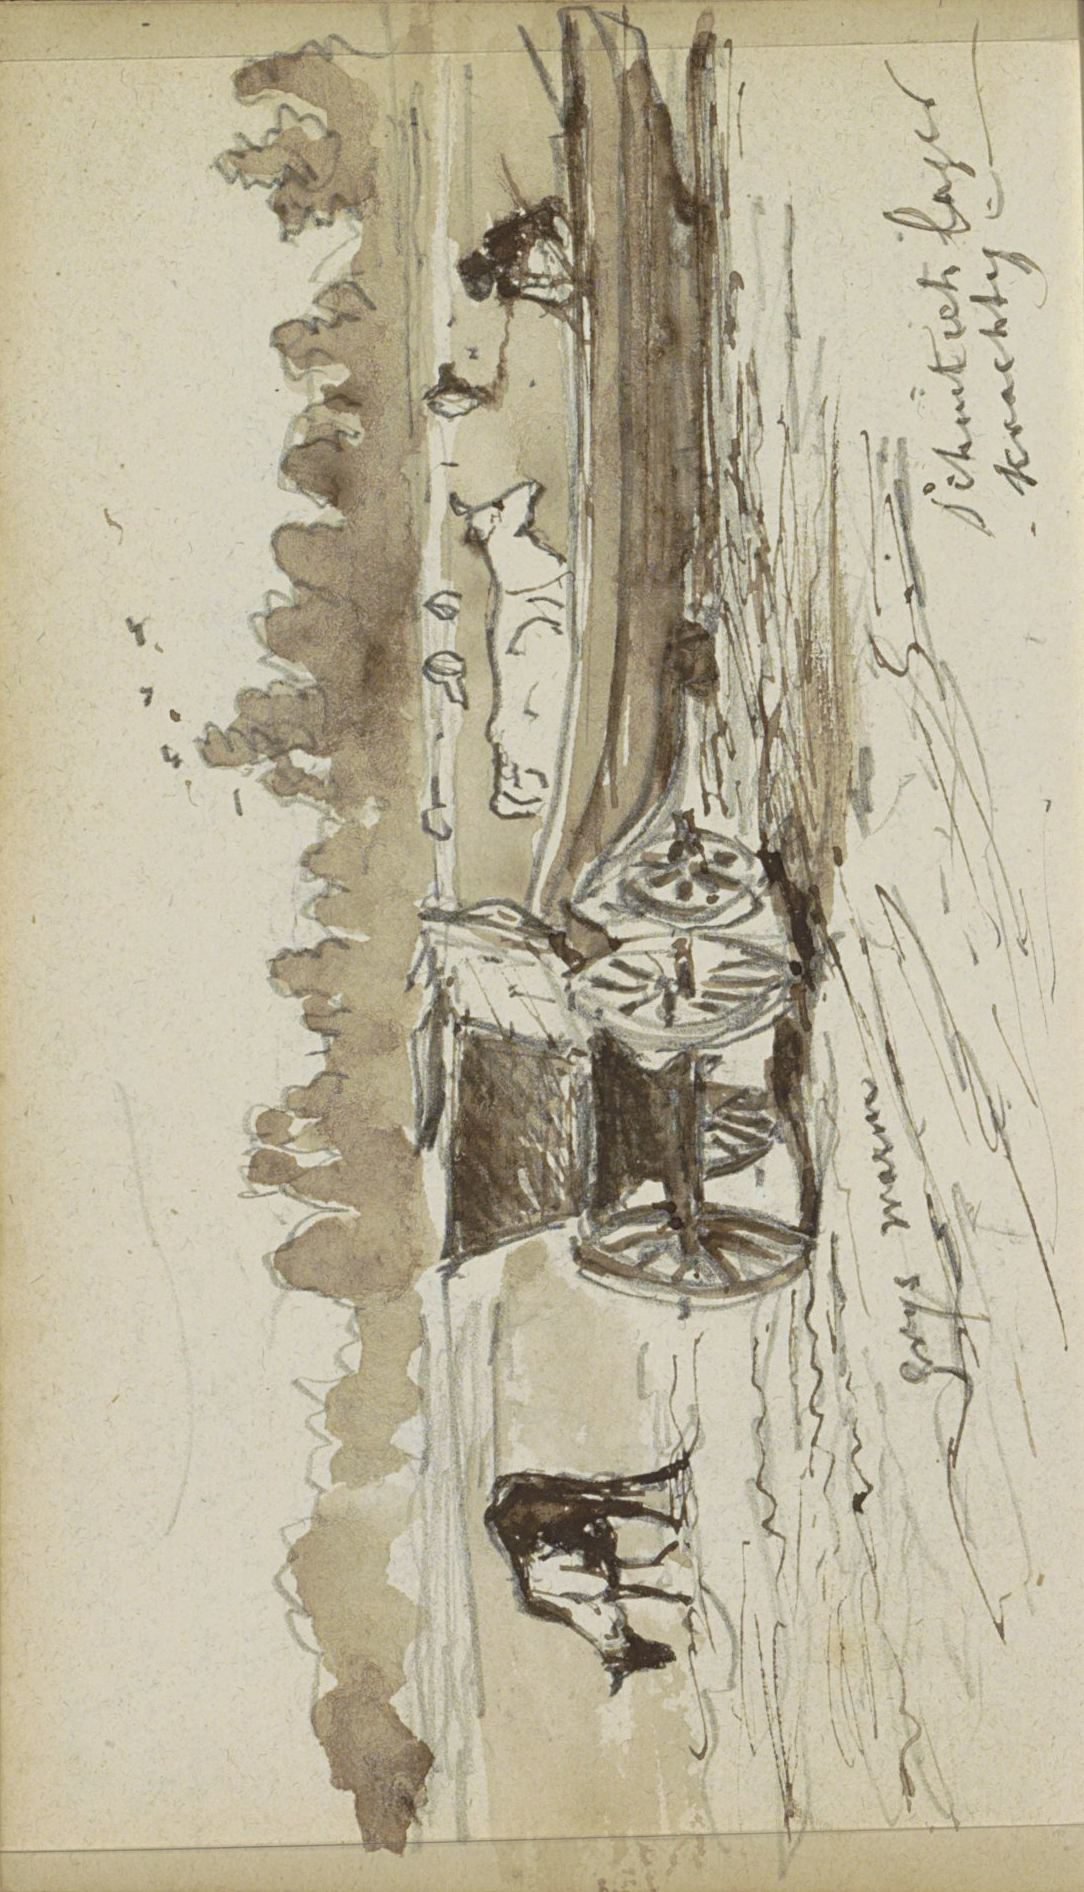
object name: sketchbook leaf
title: Weiland met koeien en een hooiwagen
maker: johannes tavenraat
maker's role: draughtsman, painter, print maker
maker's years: 1809-1881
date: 1854-1868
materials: ink, paper, pencil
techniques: brush, pen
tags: cow, meadow, pasture, hay-wagon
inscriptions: kleurnotitie, handgeschreven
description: Blad 63 verso uit een schetsboek met 88 bladen.